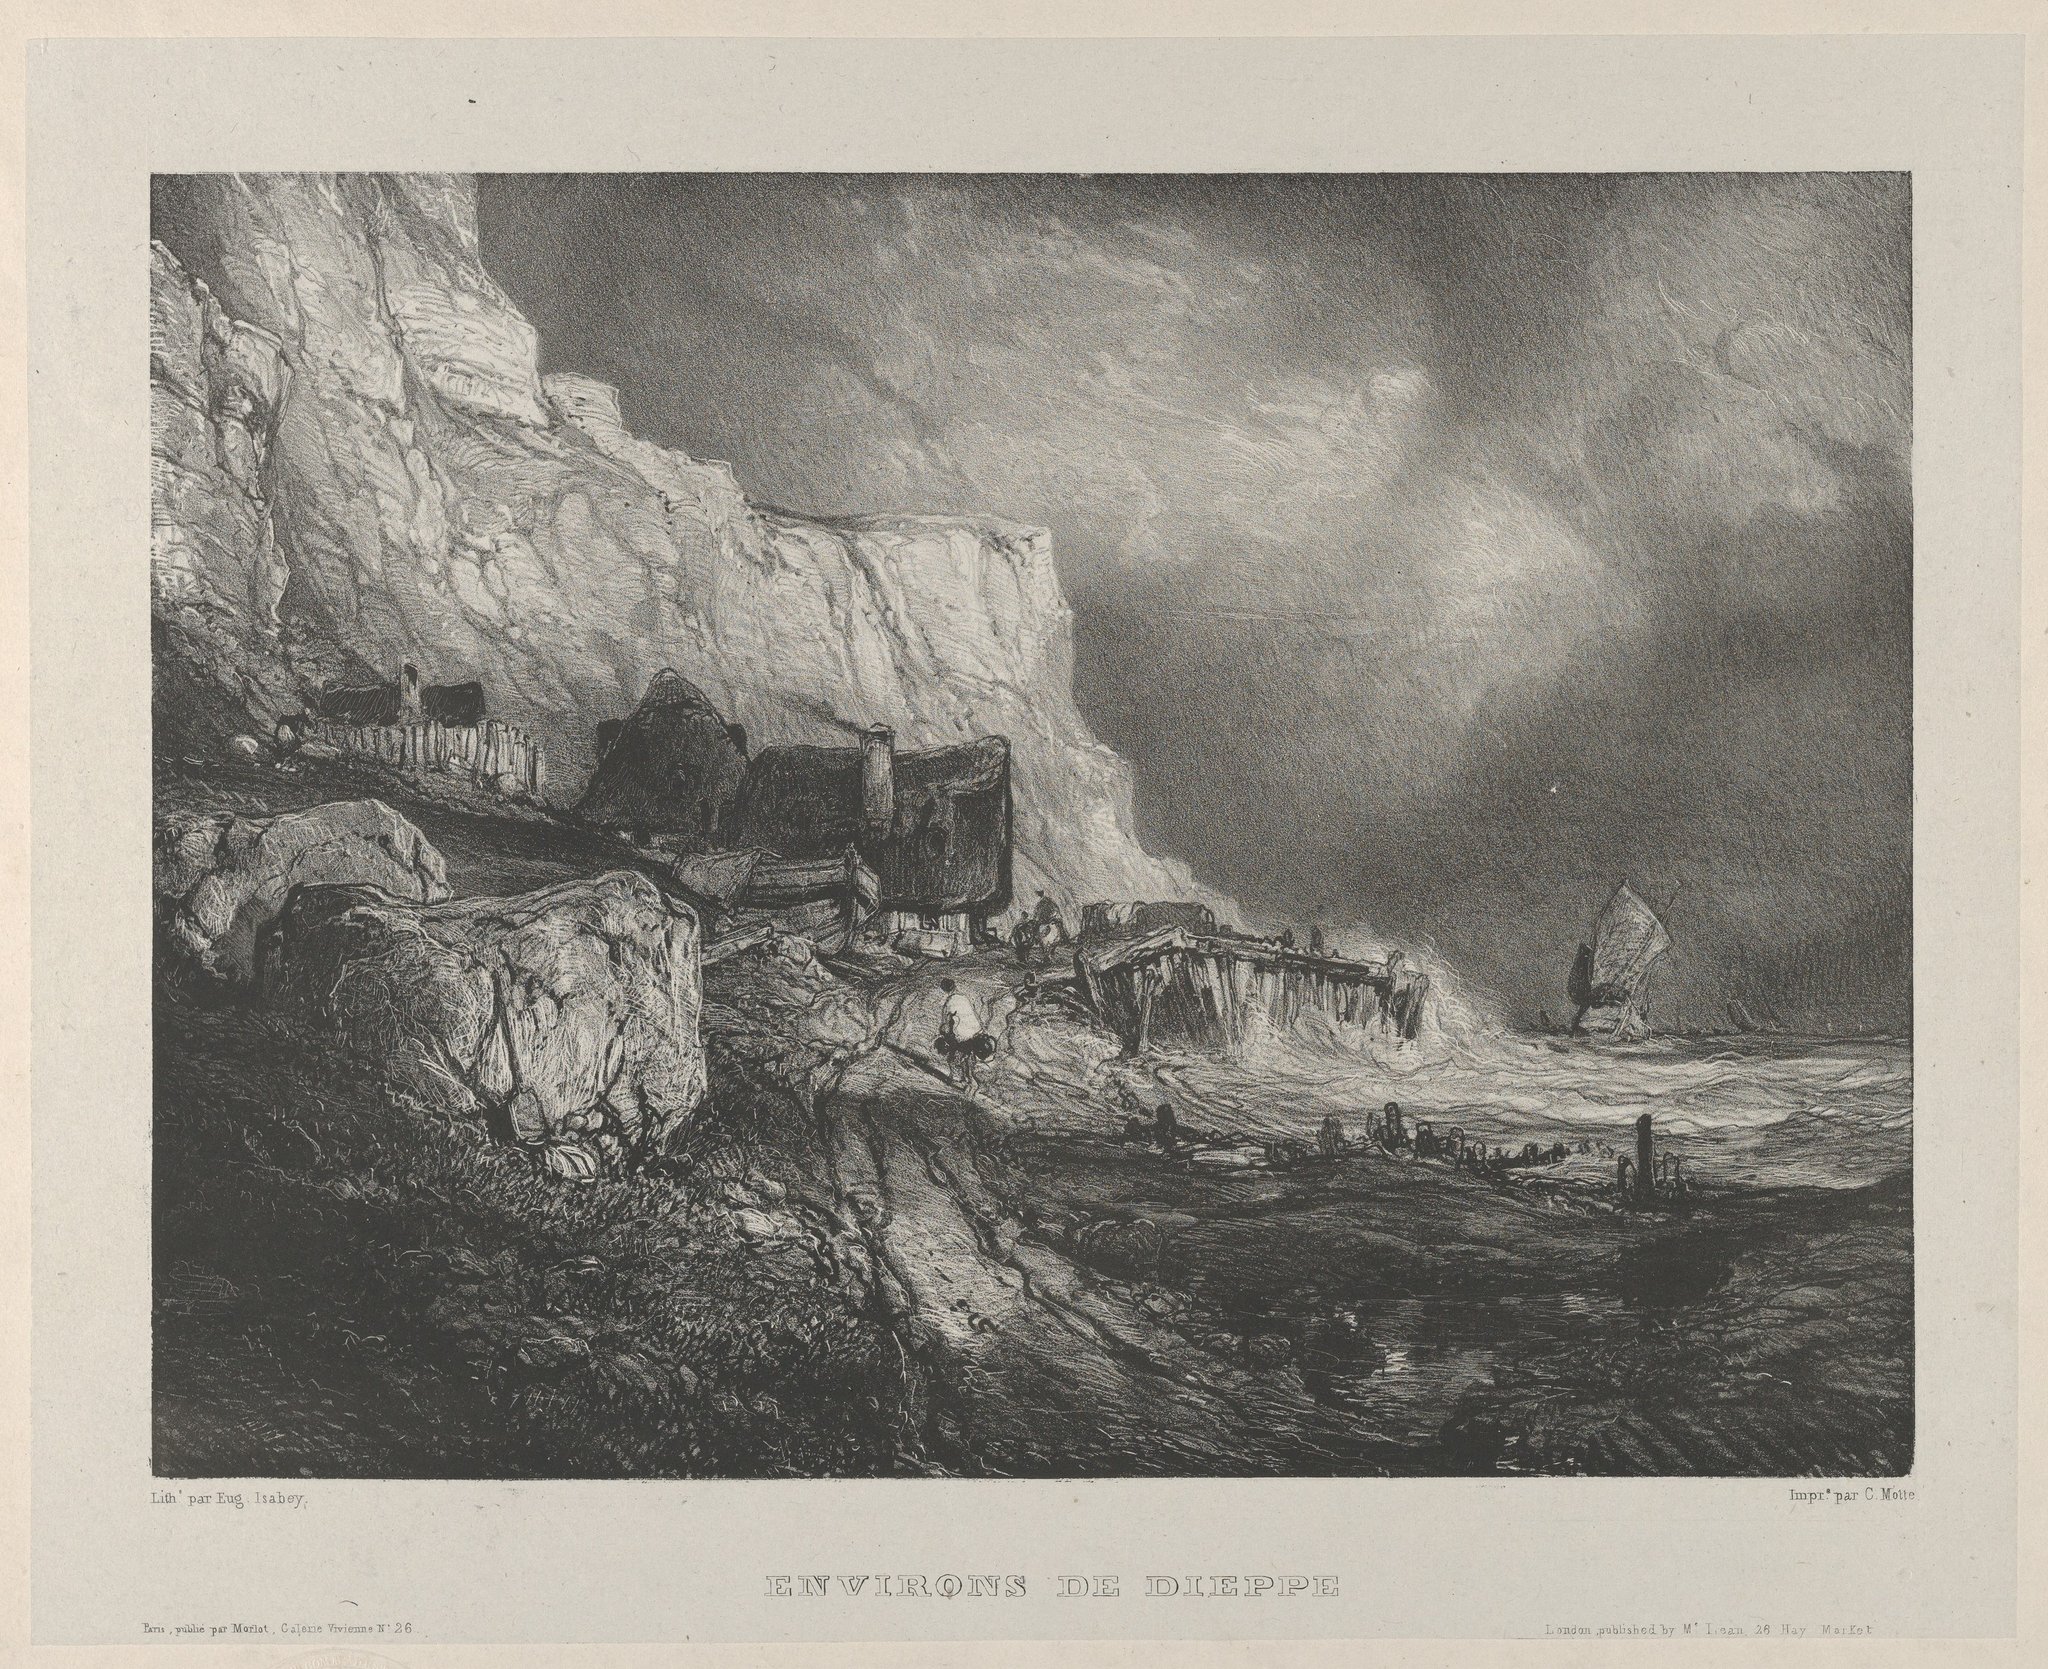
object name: print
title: The Surroundings of Dieppe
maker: eugène isabey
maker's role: artist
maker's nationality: french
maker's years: 1803-1886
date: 1833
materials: paper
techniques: printmaking, lithograph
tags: seascapes